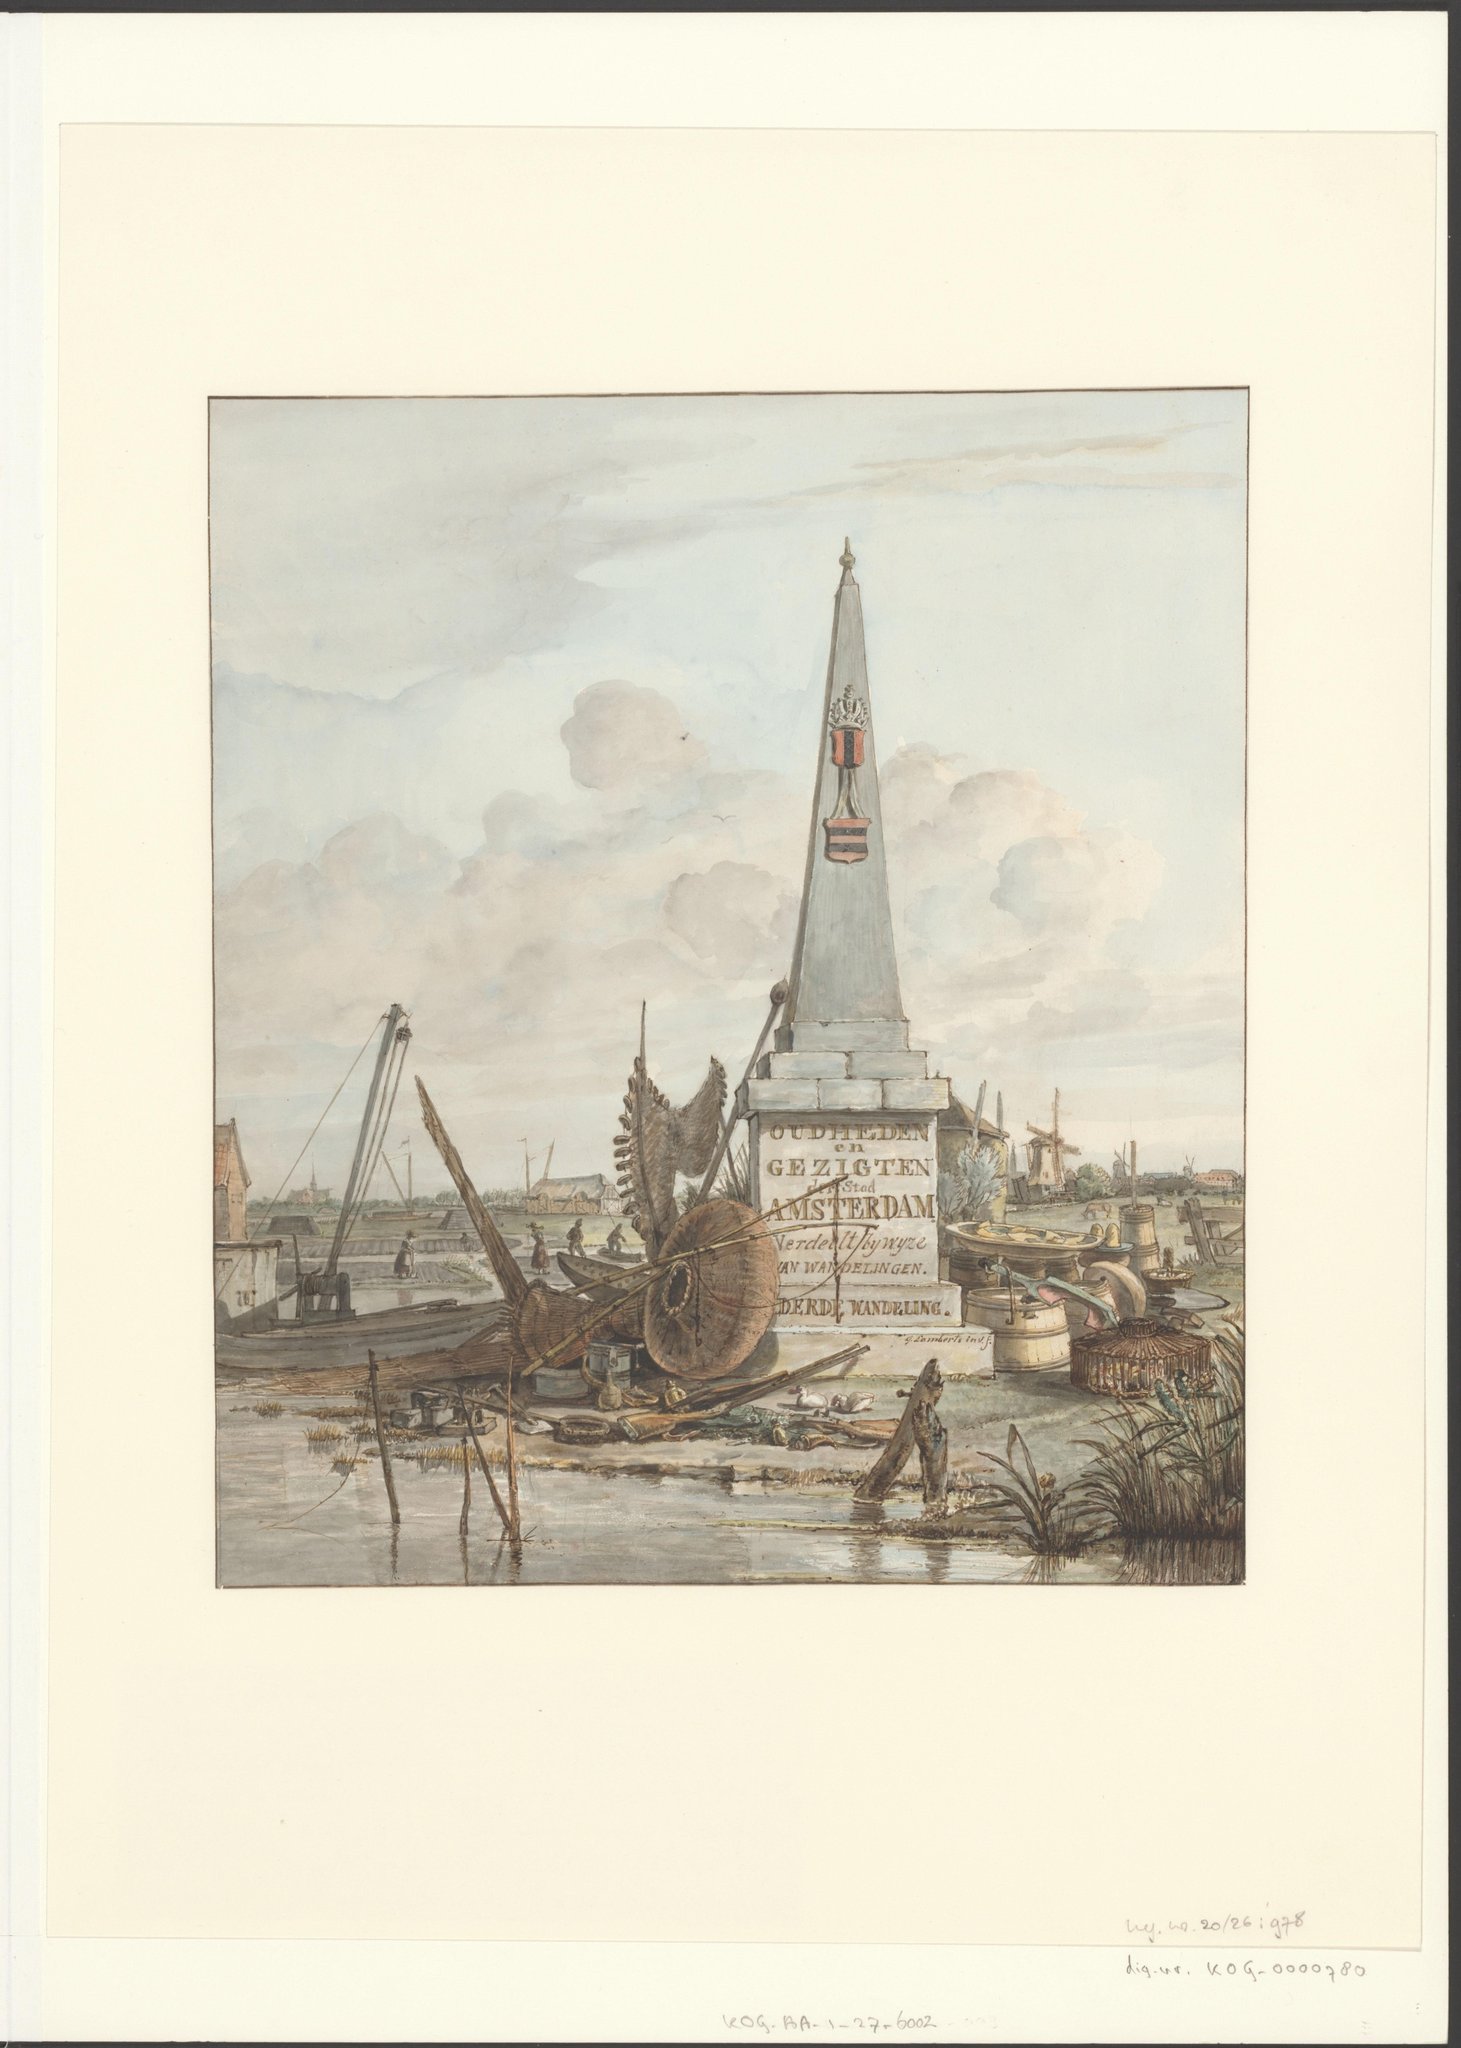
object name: drawing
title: Gezicht op de mijlpaal van Amstelveen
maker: gerrit lamberts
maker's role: bookseller, draughtsman, print maker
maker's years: 1776-1850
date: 1786-1850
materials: ink, paper, pencil, watercolor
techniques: brush, pen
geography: amsterdam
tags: obelisk, needle, city-view in general; 'veduta'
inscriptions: inscription: ‘Deezen [...]ytel voor (...) door Gerrit Lamberts.’, signature: ‘G. Lamberts inv. f.’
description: Onderwerpsrubriek binnen de Atlas Amsterdam: Landmacht: Gebouwen / Heinneringen aan officieren, stadssoldaten / Nationale militie / (diverse korpsen) / Padvinders / Parade.